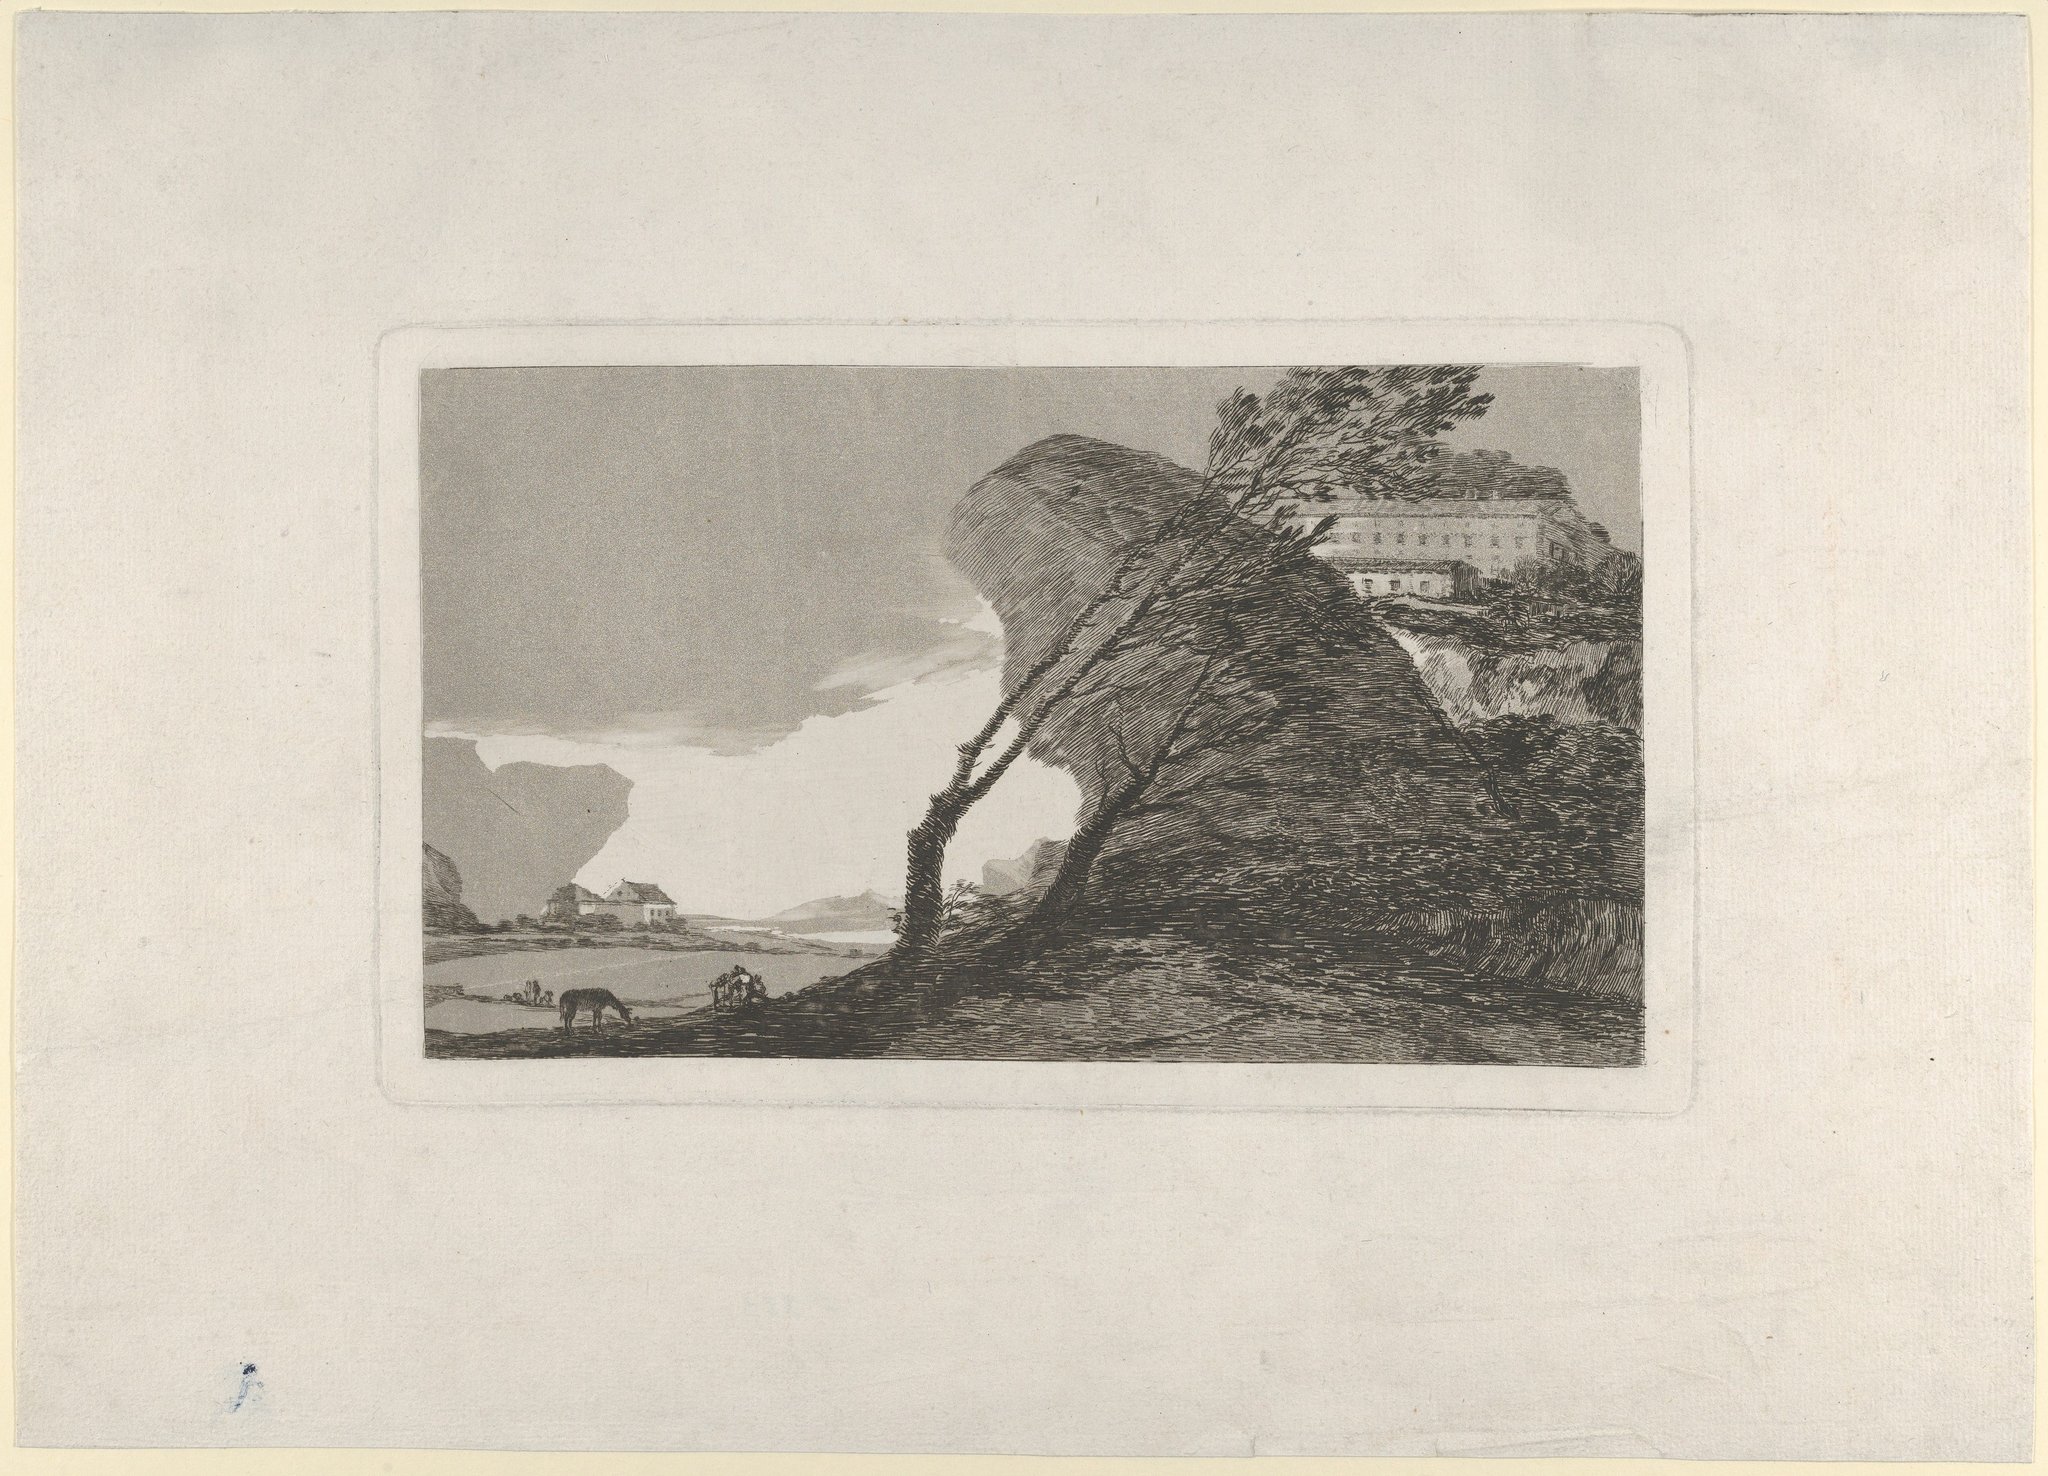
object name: print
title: Landscape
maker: goya (francisco de goya y lucientes)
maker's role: artist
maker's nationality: spanish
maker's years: 1746-1828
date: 1807-1810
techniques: aquatint, etching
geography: spain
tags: buildings,landscapes,trees